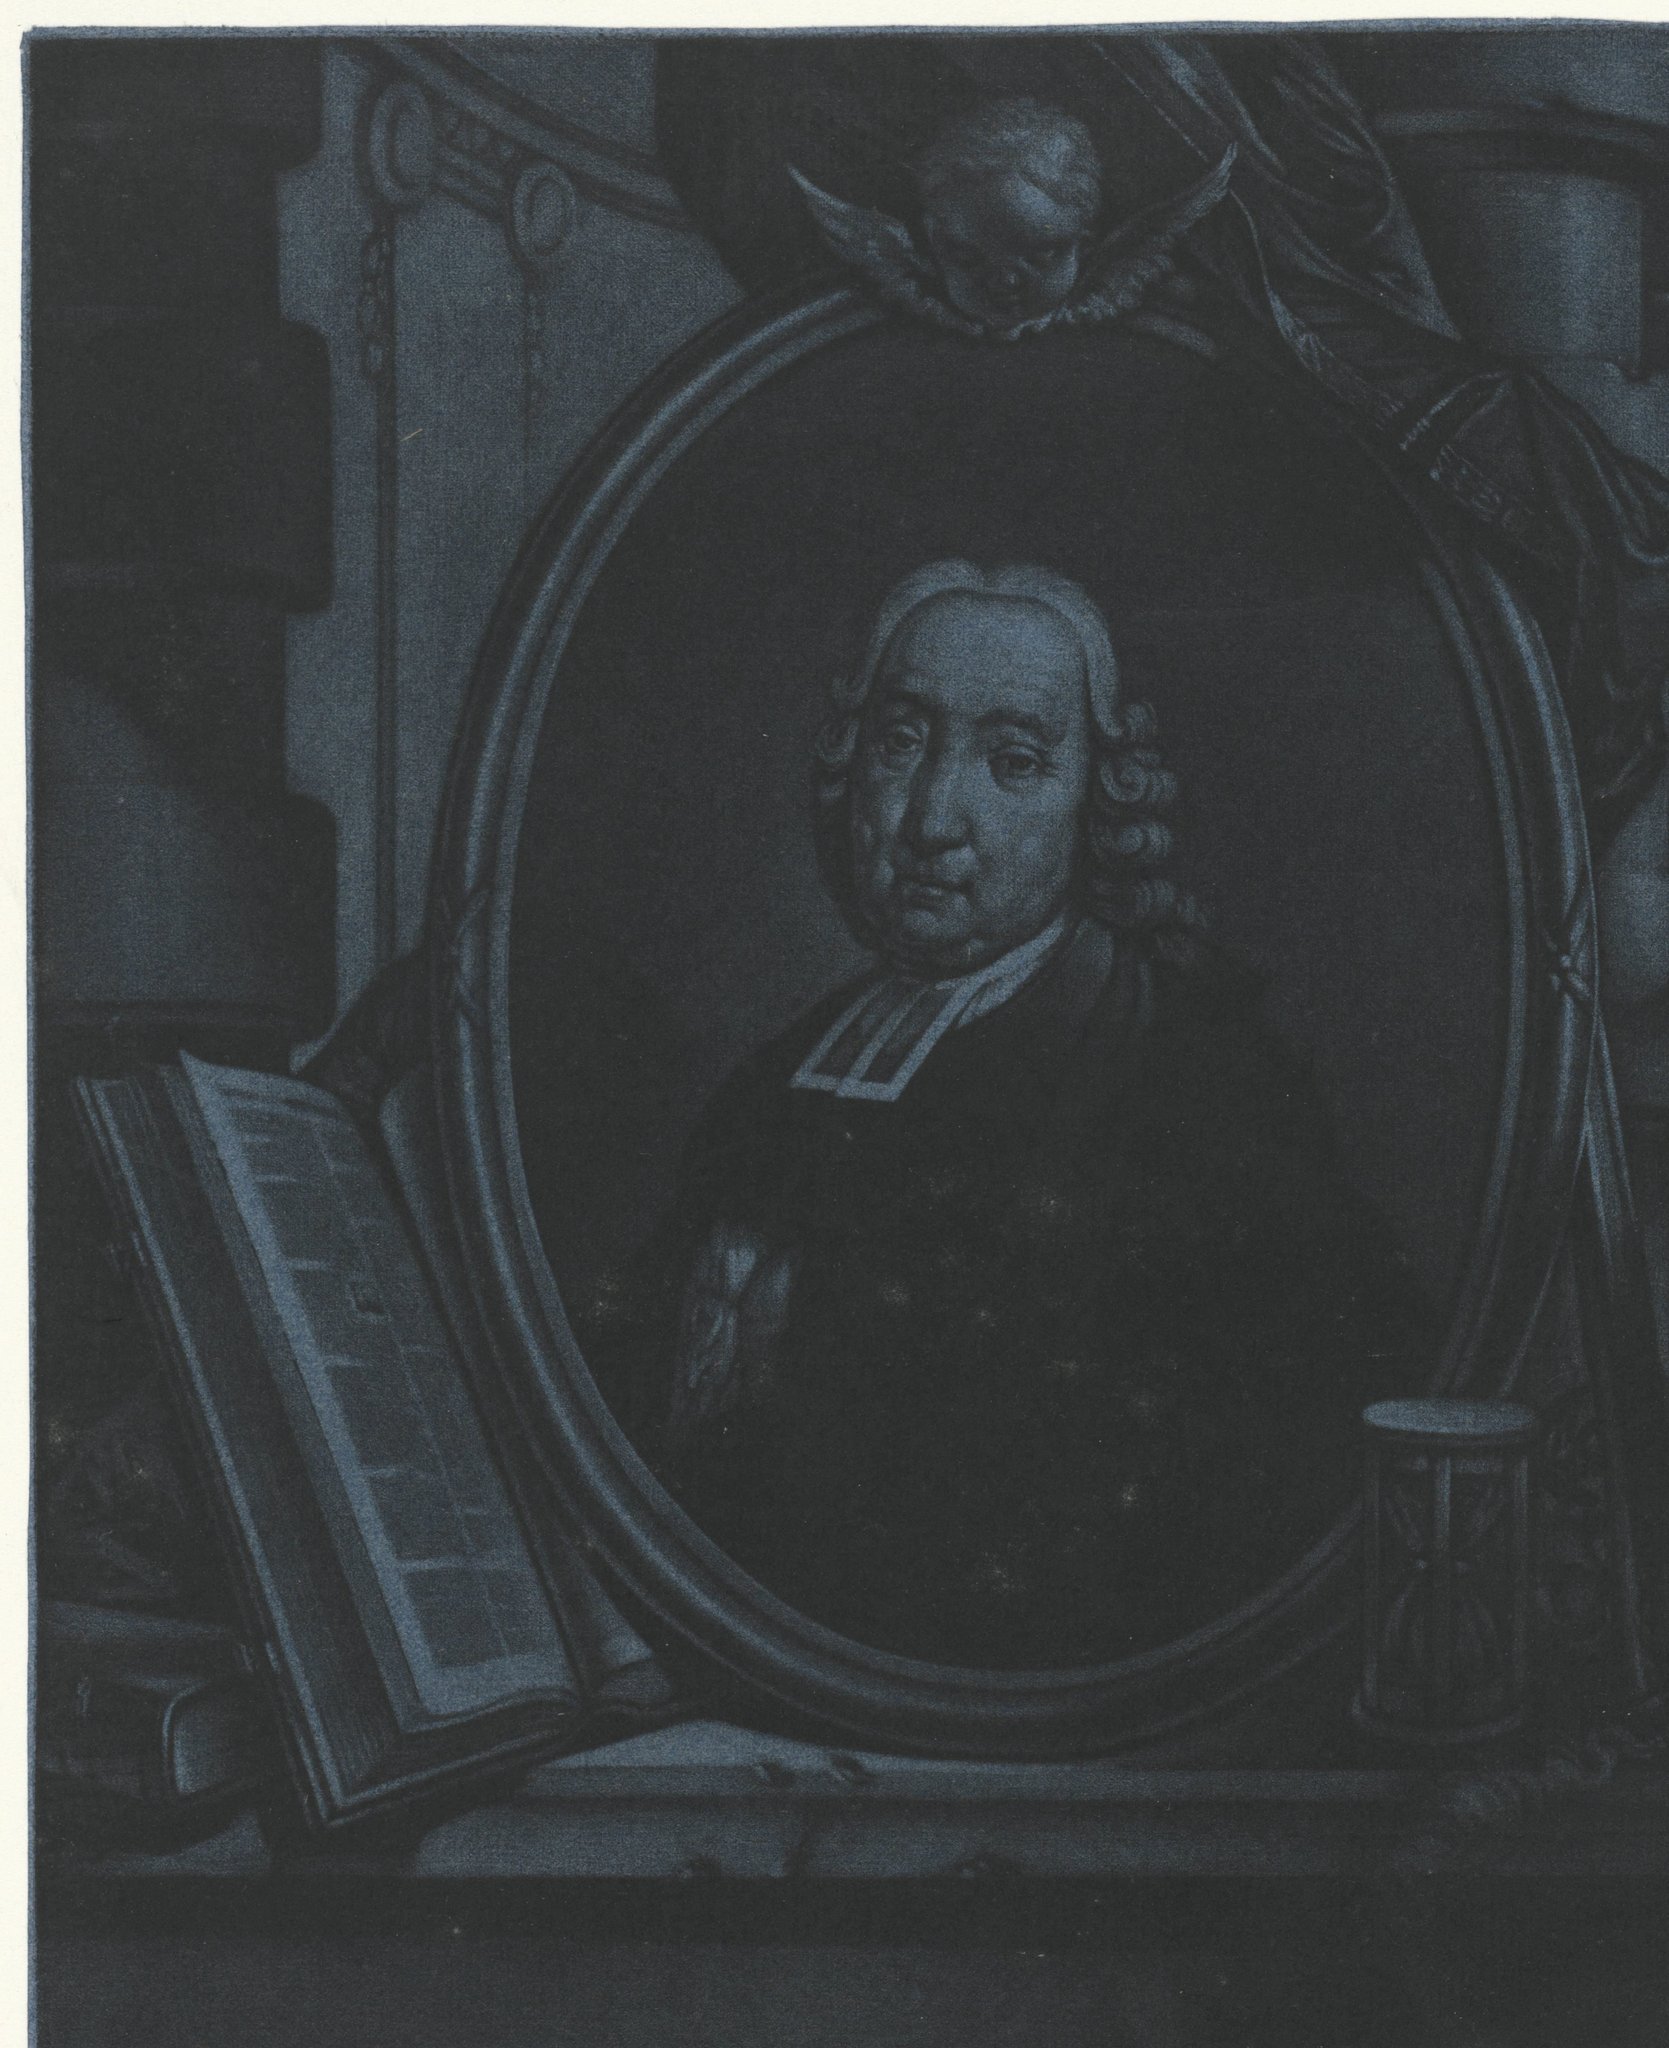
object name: print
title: Portret van Petrus van Ede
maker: jan stolker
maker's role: draughtsman, painter, print maker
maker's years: 1724-1785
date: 1759-1785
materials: paper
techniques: mezzotint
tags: historical persons, 'vanitas' symbols, hourglass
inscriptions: collector's mark: Lugt 240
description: Petrus van Ede, predikant te Rotterdam. Om de omlijsting verschillende vanitassymbolen zoals een gedoofde kaars, een zandloper en een gelauwerde schedel.